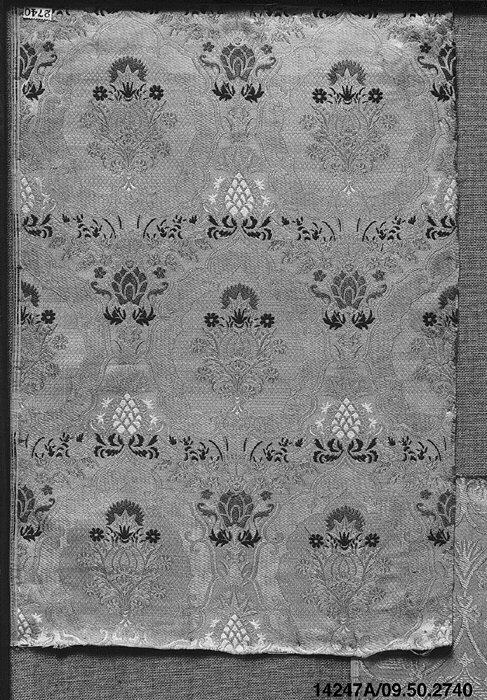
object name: piece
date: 1801-1900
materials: silk